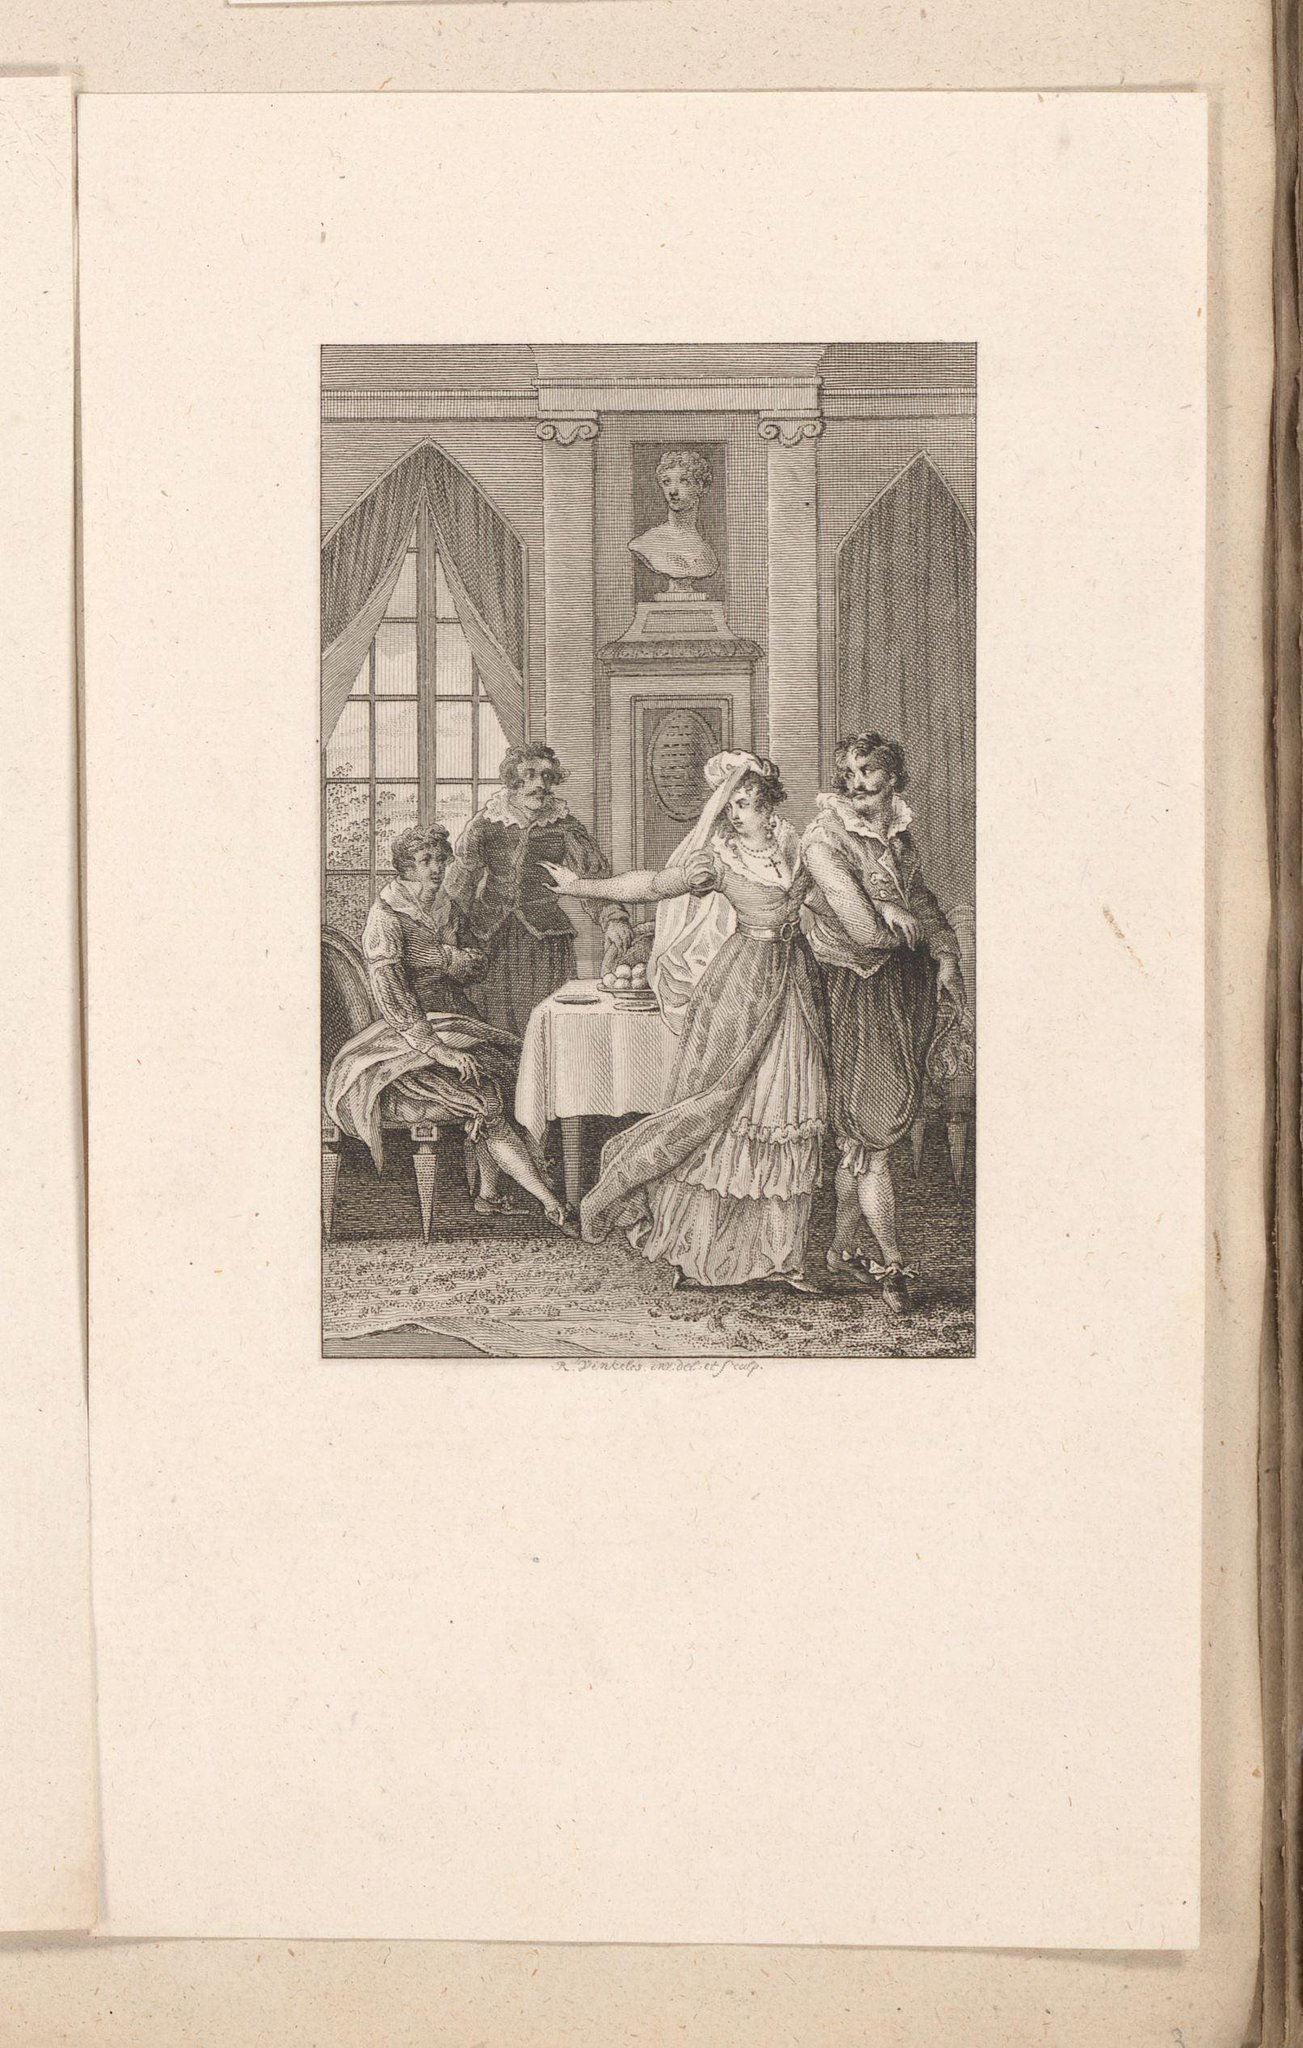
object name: album leaf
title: Paar verlaat beledigd een vertrek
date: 1808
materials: paper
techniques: engraving, etching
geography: haarlem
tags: mocking, insulting; teasing, taking leave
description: Proefdruk van een boekillustratie in: Loosjes, Adriaan Pietersz. Het leven van Maurits Lijnslager: eene Hollandsche familiegeschiedenis uit de zeventiende eeuw. Haarlem: Adriaan Pietersz. Loosjes, 1808.